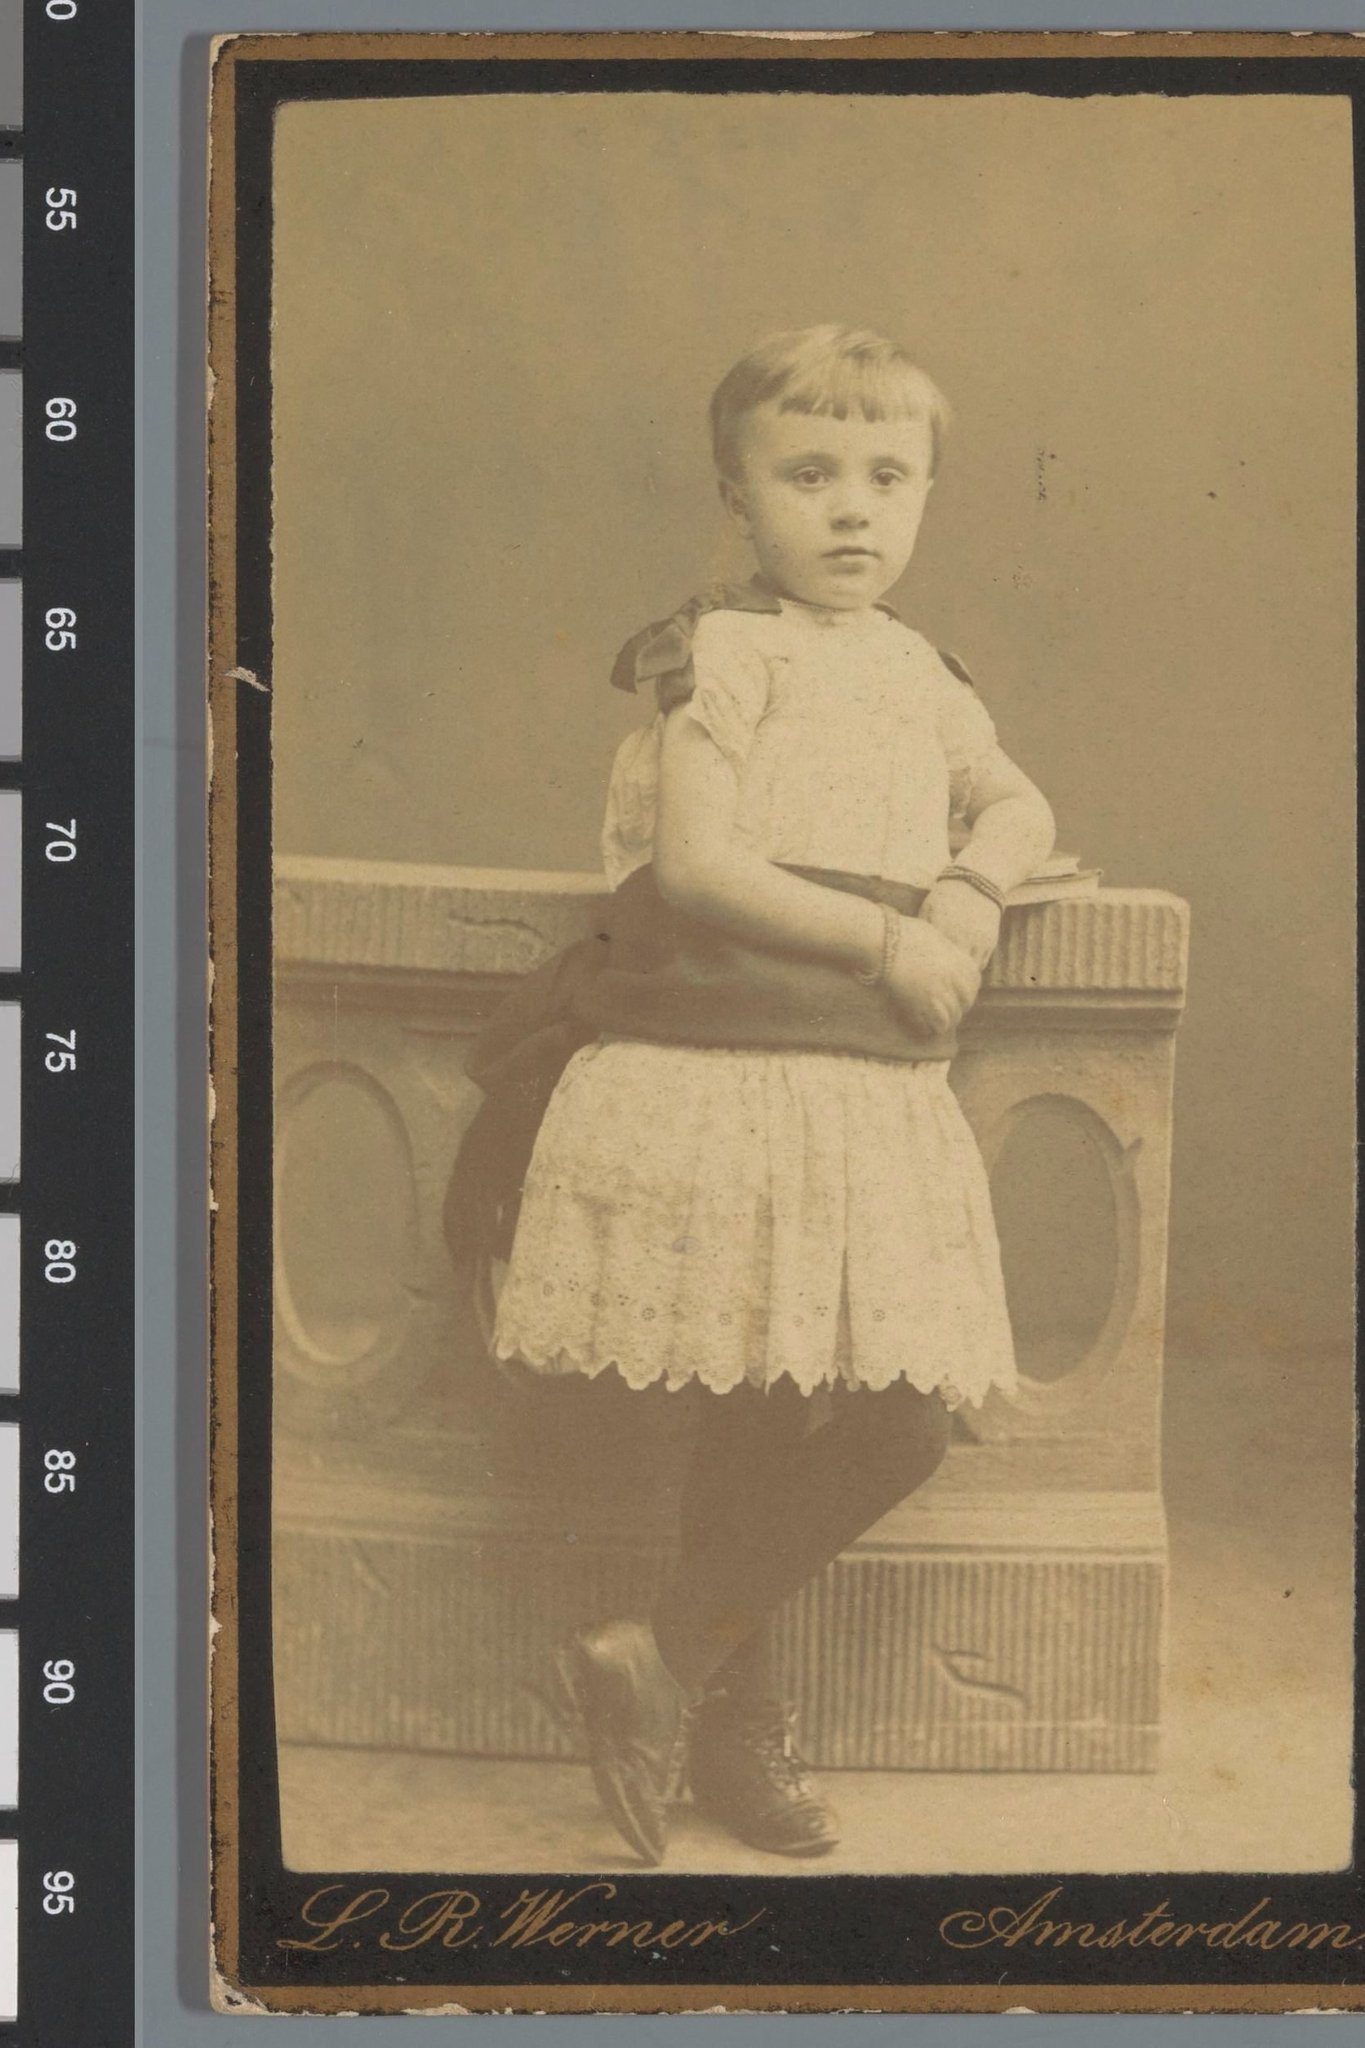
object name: carte de visite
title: Portret van een onbekend kind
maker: louis robert werner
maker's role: fotograaf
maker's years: 1834-1896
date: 1878-1886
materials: cardboard, paper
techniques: albumen print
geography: amsterdam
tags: child, anonymous historical person portrayed, amsterdam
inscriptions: inscription: ‘L.R. Werner Amsterdam’, number: ‘6/ 9’, inscription: ‘L.R. Werner/ voorheen P. Carstensen/ Amsterdam/ Nieuwendijk H 150./ Nabestellingen en vergrotingen/ ook van anderen Portretten, kunnen iederen tijd/ geleverd worden.’